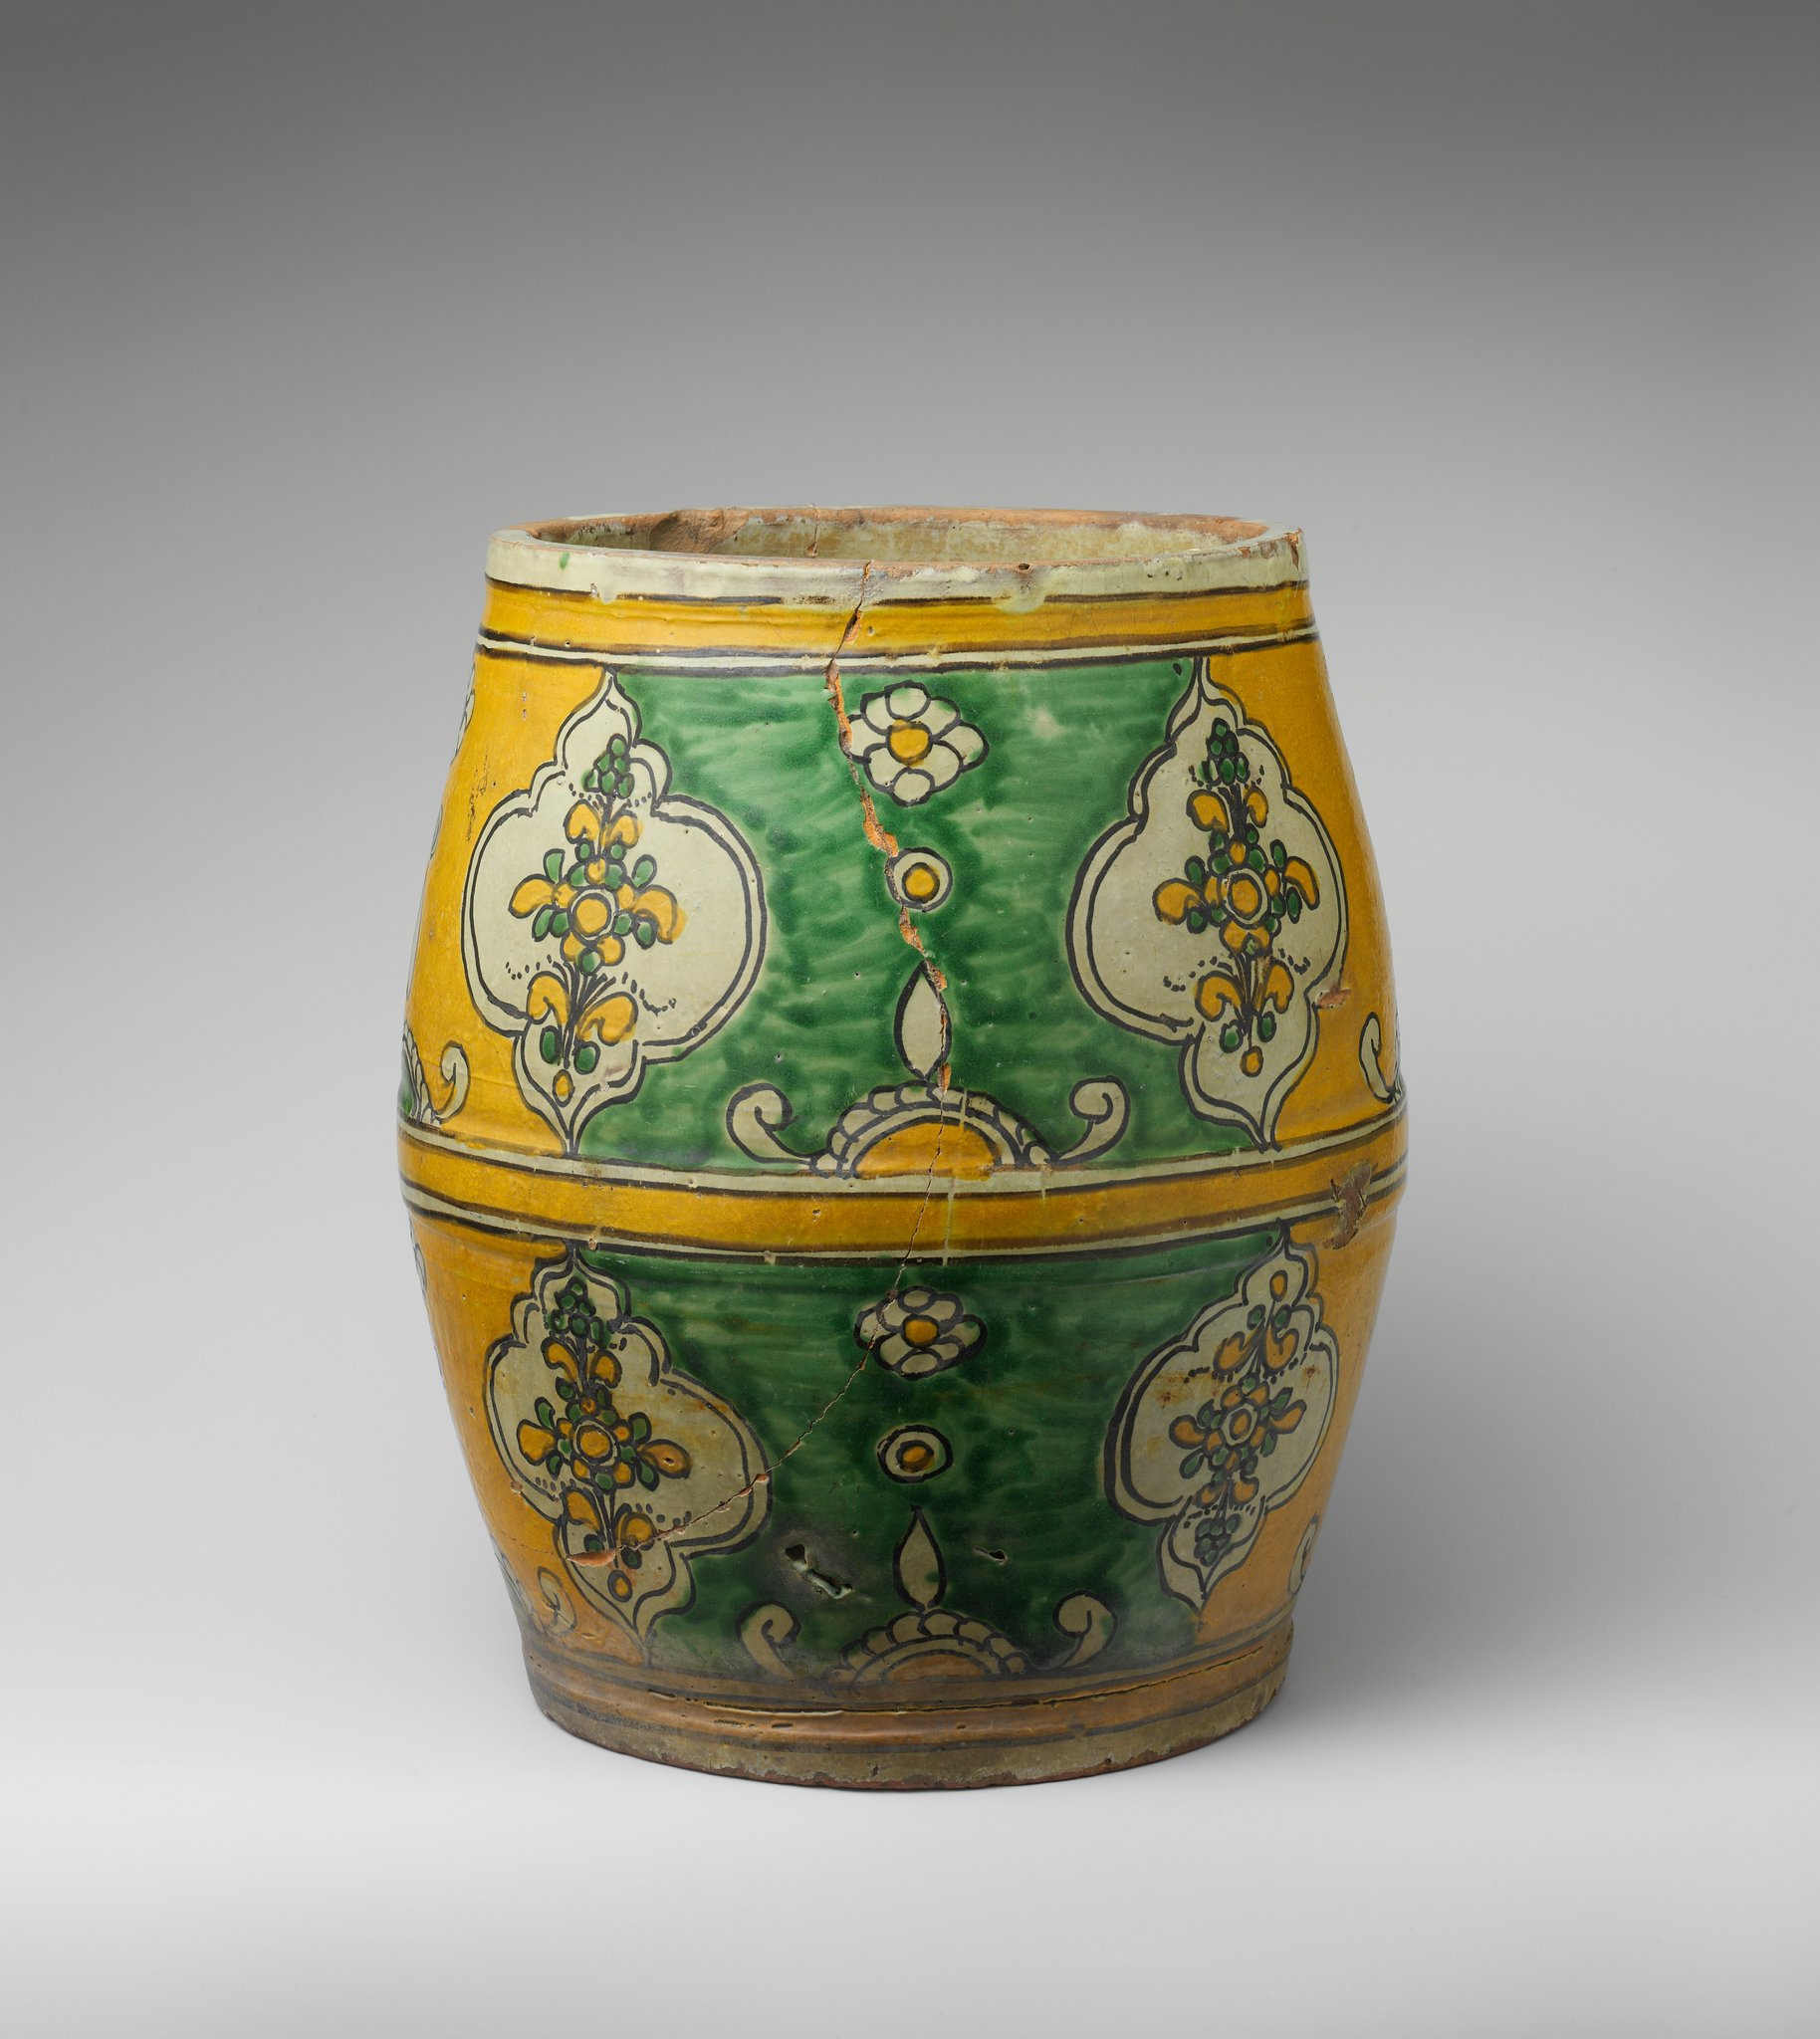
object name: flower pot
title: Barrel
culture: mexican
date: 1830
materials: earthenware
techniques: glazing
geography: mexico